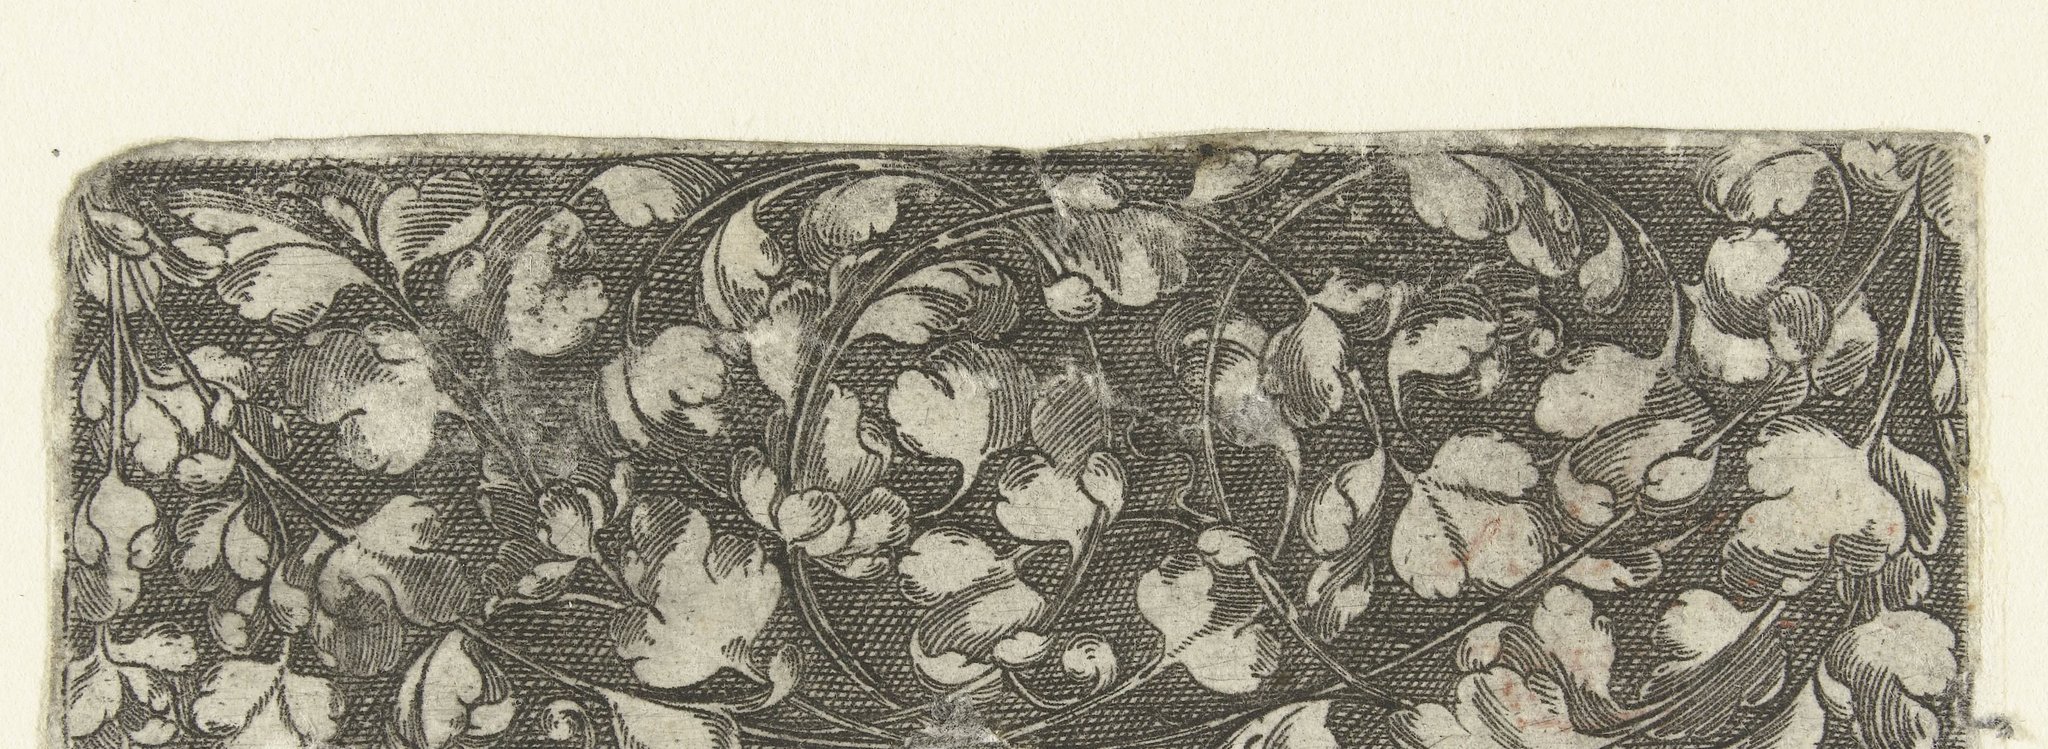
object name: print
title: Bladranken die aan beide uiteinden van het fries ontspruiten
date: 1500-1600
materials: paper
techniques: engraving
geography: germany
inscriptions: collector's mark: Lugt 240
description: De bladranken vormen naar het midden toe voluten die elkaar kruisen. Gearceerde achtergrond. Eén van 11 bladen.